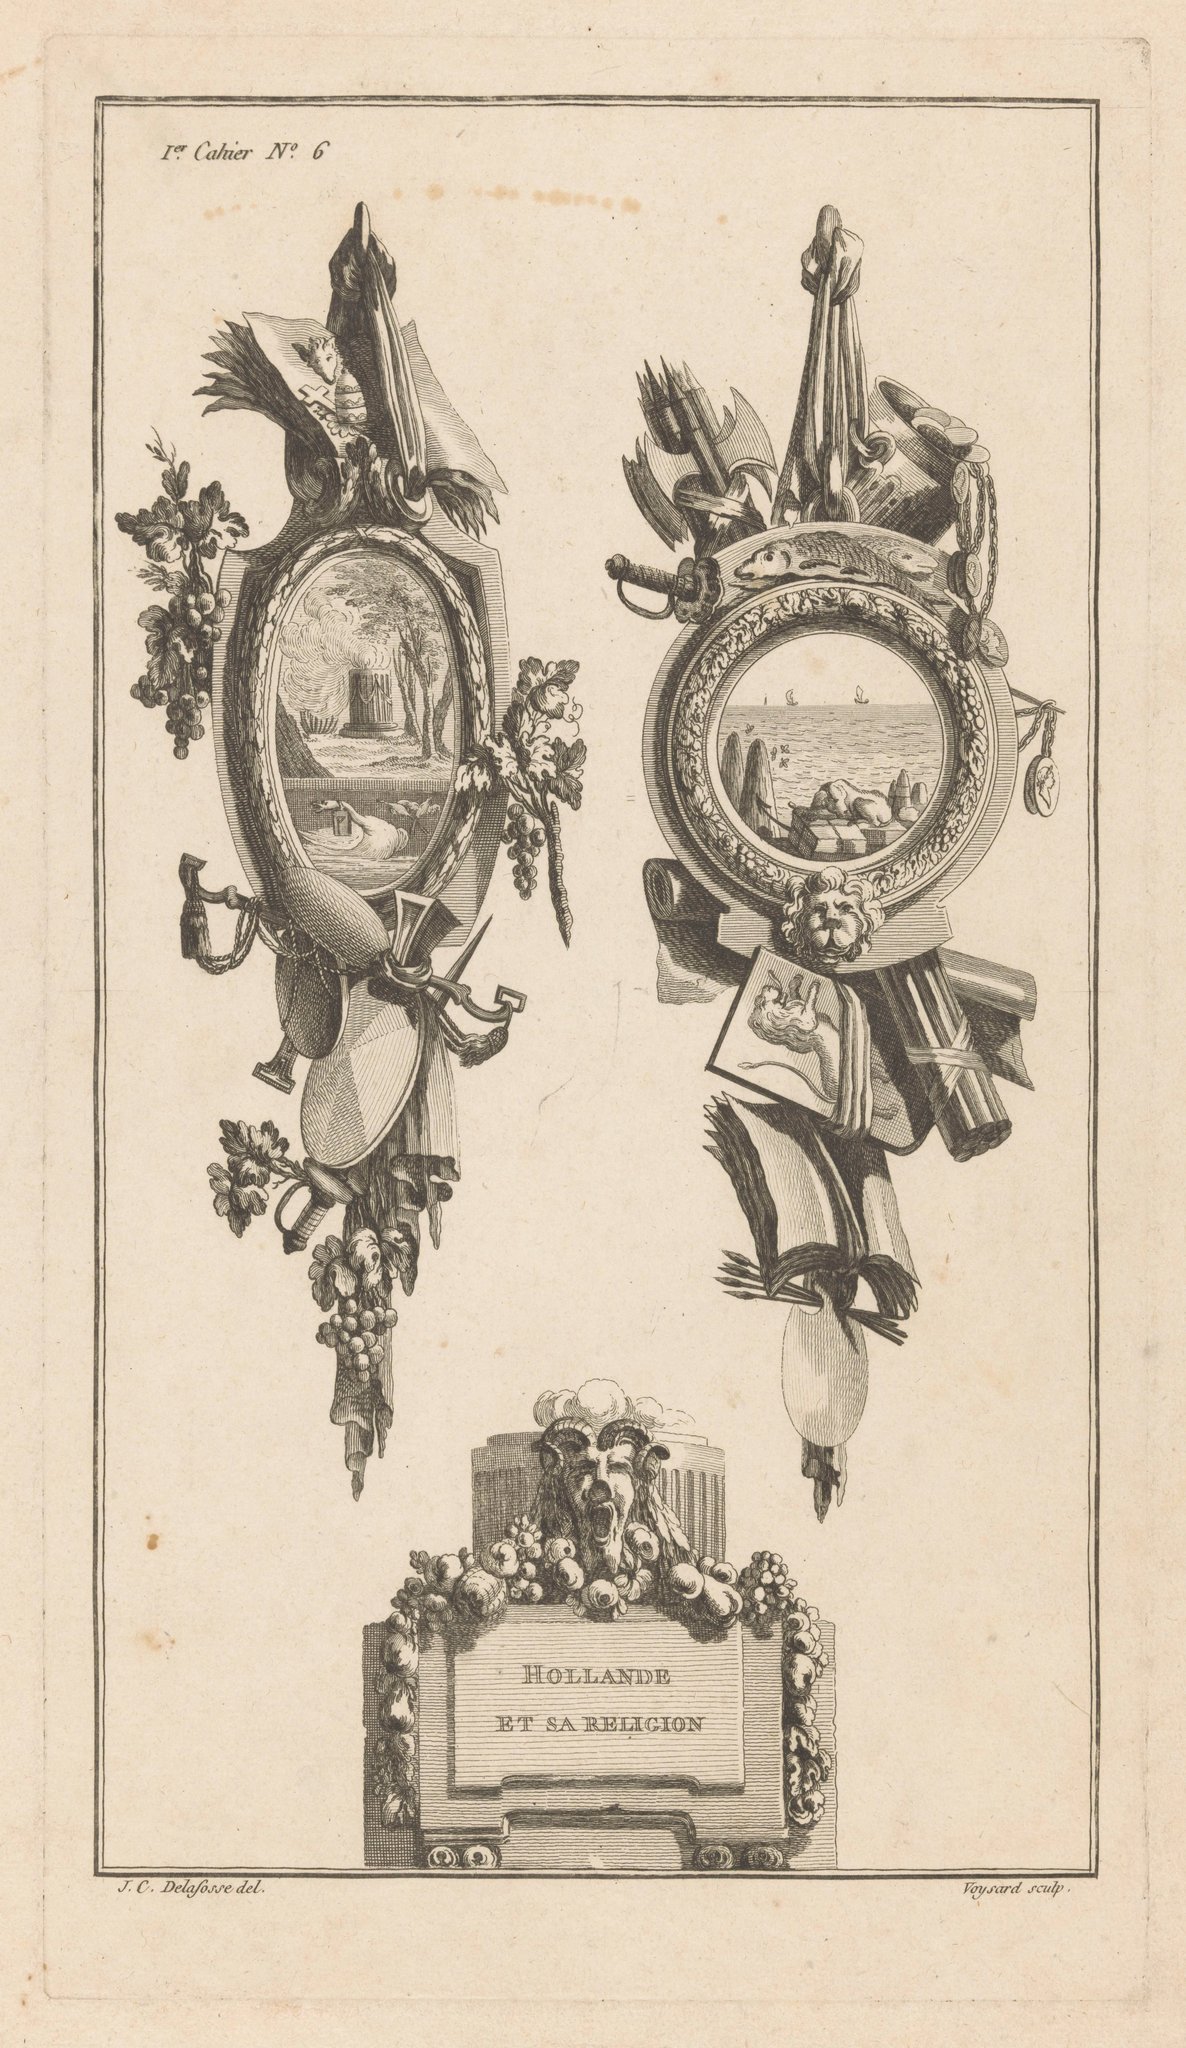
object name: print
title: Trofeeën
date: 1772-1779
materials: paper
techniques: engraving, etching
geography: paris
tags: trophy, i.e.: decorative arrangement of symbolic or typical objects ~ ornament, symbols of particular nations, states, districts, etc., holland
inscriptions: collector's mark: Lugt 2760, collector's mark: Lugt 2228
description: Twee trofeeën met schilden. Links met een boek, druivenranken en een ovaal schild met een zwaan en een rookvat. Rechts met wapens, een schilderspalet, een leeuw en een rond medaillon met een hond aan zee.